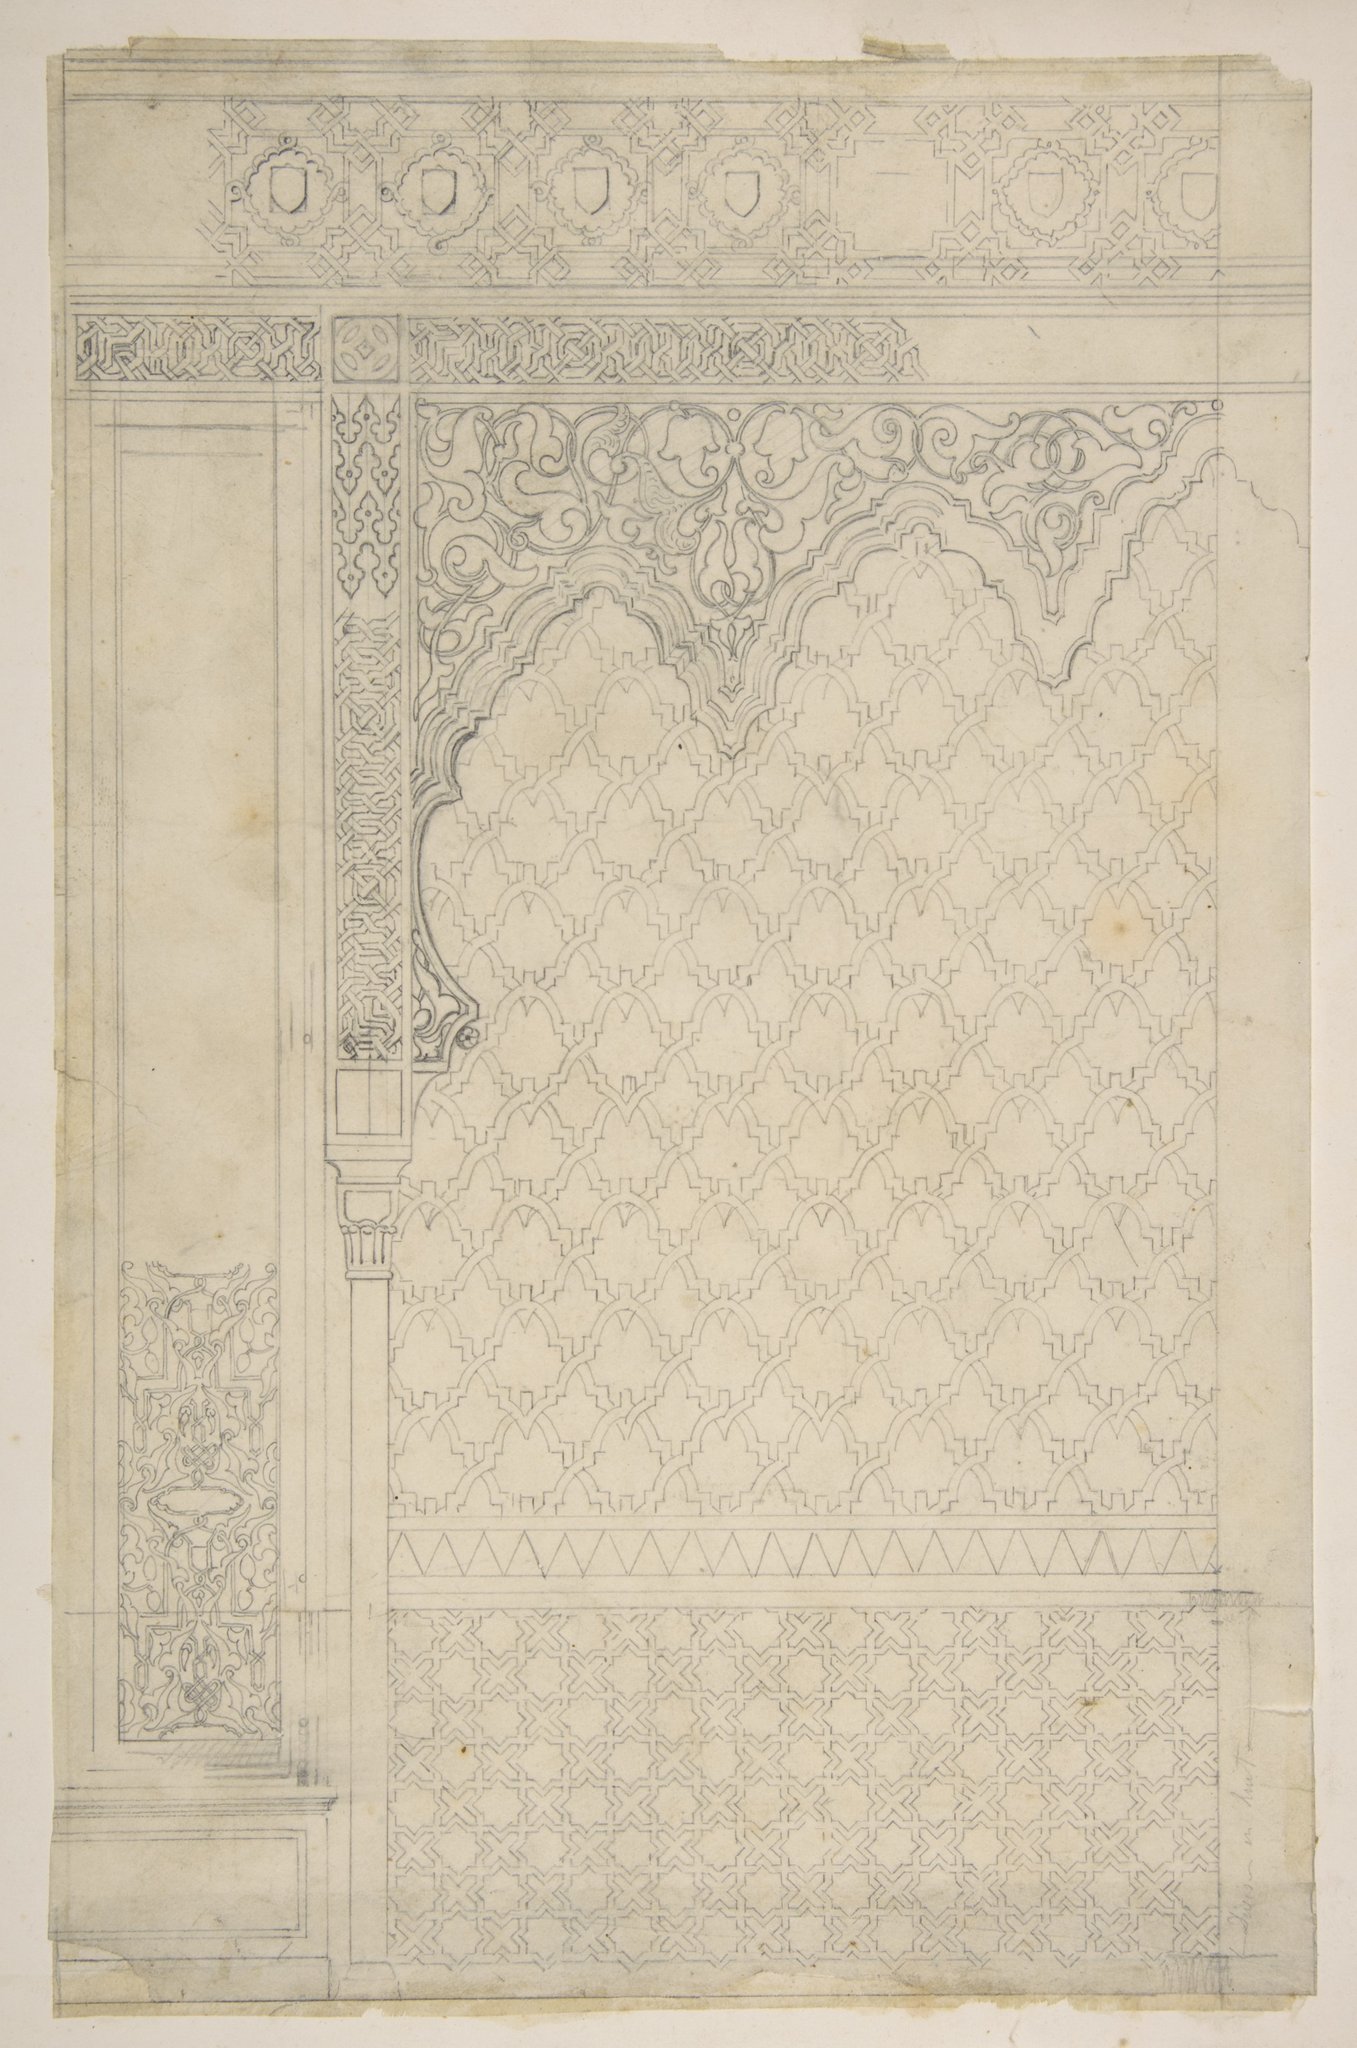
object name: drawing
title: Design for the decoration of a wall in Islamic motifs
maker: jules-edmond-charles lachaise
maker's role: artist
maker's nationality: french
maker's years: 1897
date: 1851-1900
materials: cardboard, graphite, paper